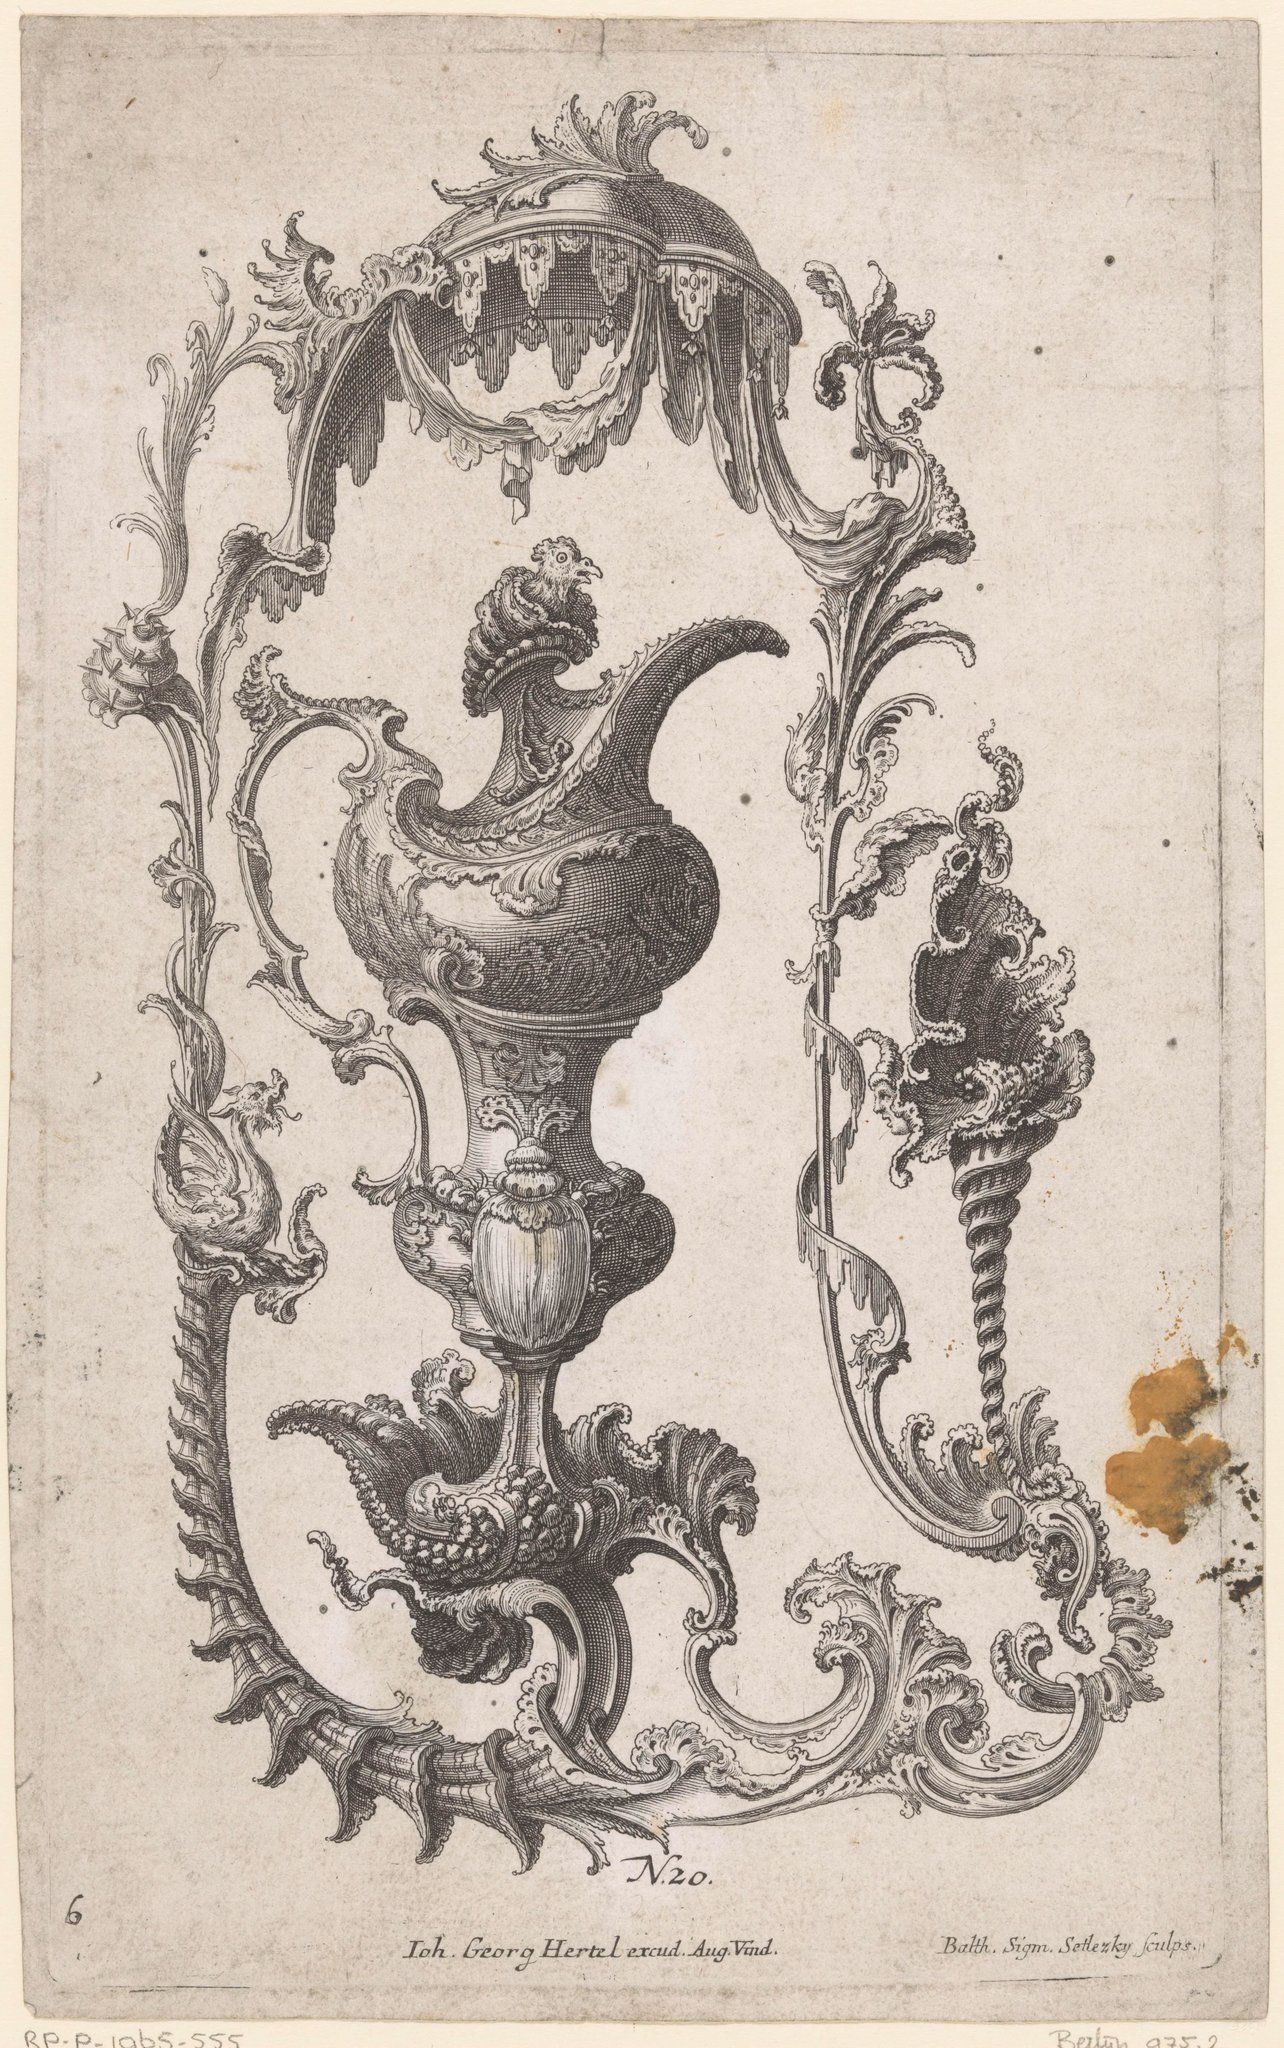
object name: print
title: Einige Vases mit modernen Einfassungen (...)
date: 1705-1771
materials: paper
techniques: etching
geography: augsburg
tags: birds, jar, jug (used as drinking-vessel)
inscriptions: collector's mark: Lugt 2228, collector's mark: Lugt 2760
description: Een sierkan met rocaille ornamenten en een vogelkop. Rondom de kan een rocaille omlijsting met draak en rocailles. Uitgeversnummer 20.